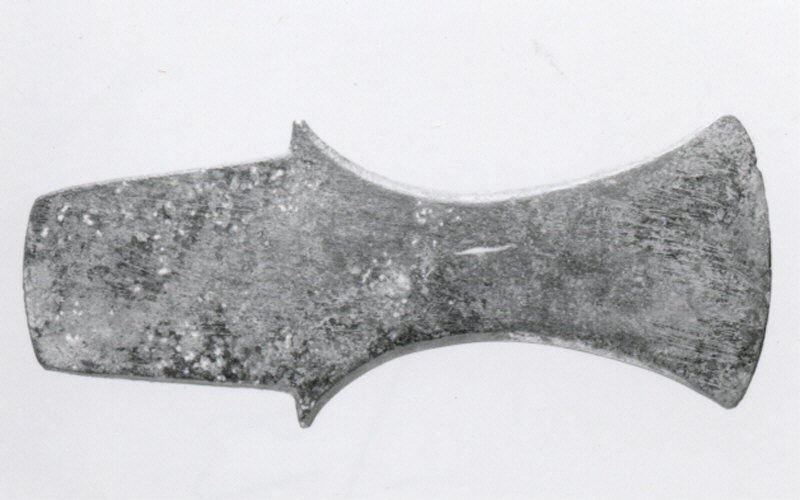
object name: axe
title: Lugged axe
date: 2000-1001 BCE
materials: copper alloy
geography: anatolia